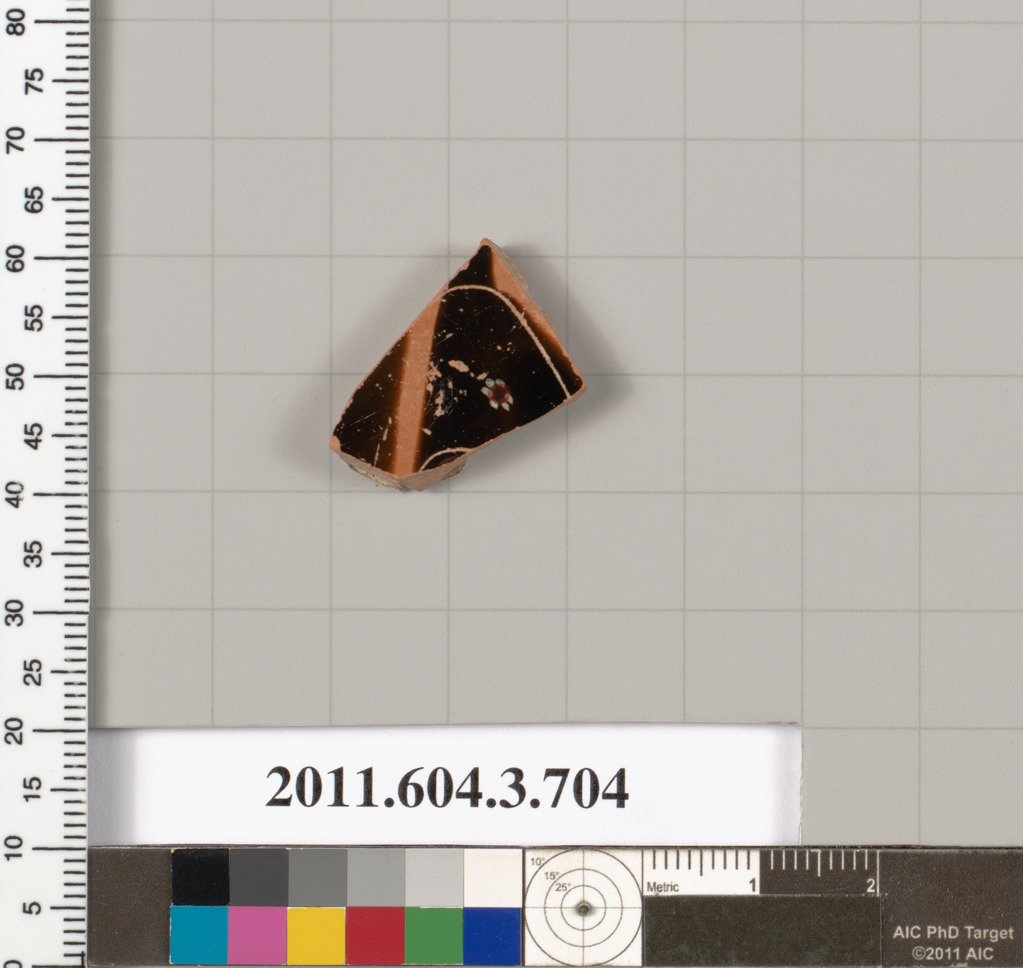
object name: hydria fragment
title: Terracotta fragment of a hydria (water jar)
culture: greek, attic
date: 550-501 BCE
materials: terracotta